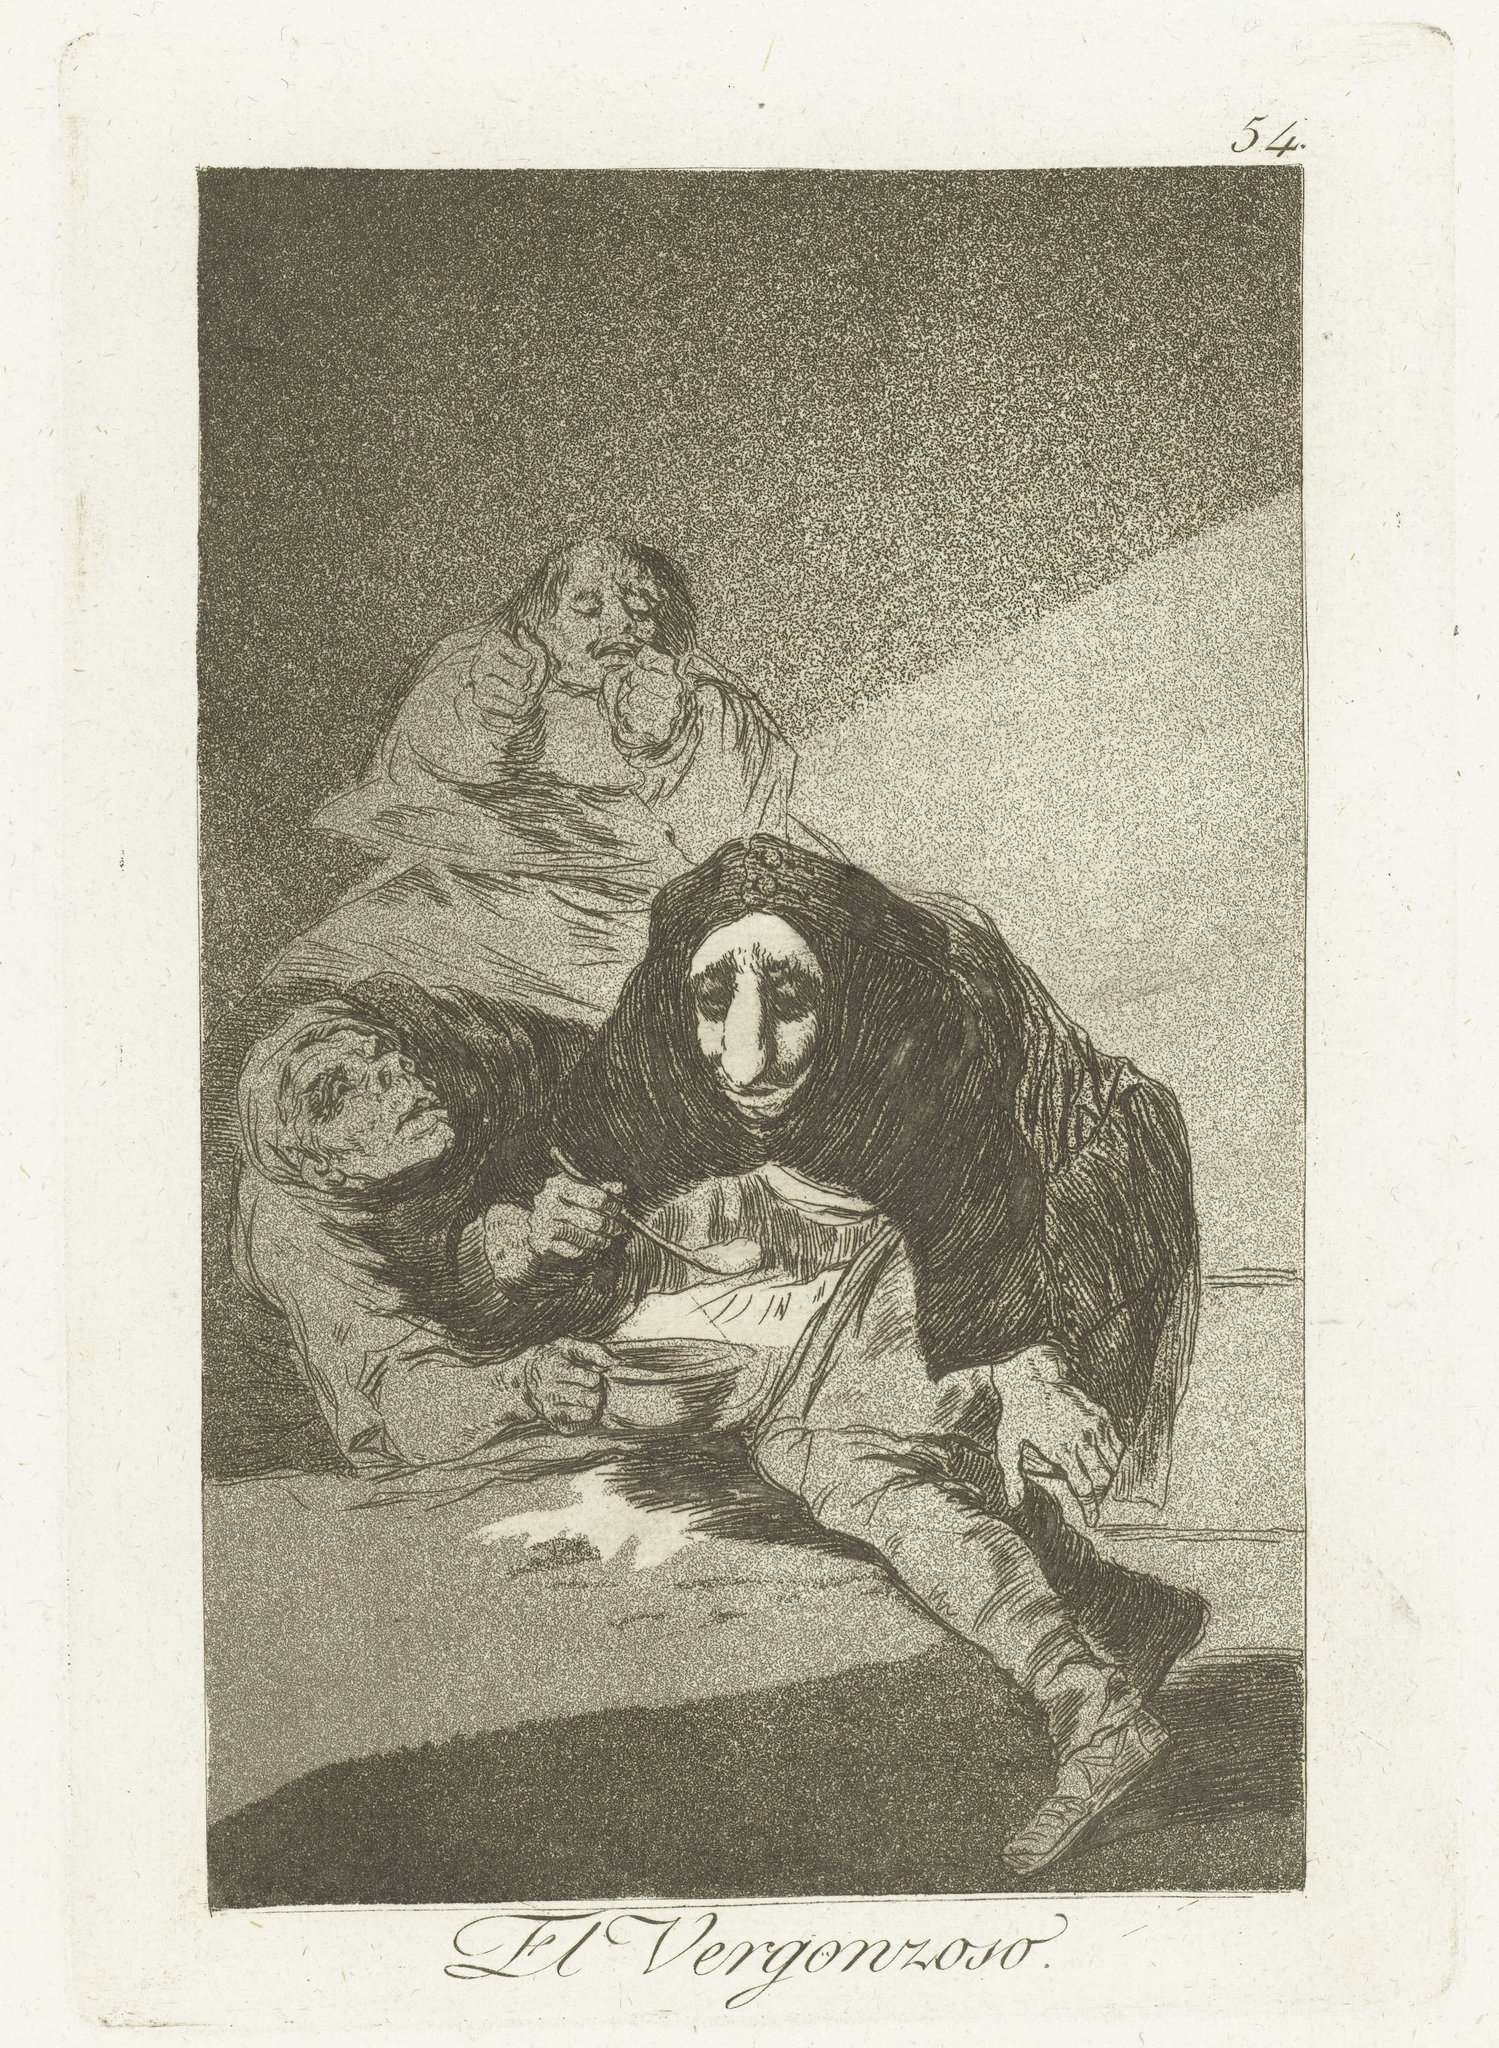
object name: print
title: El vergonzoso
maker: francisco de goya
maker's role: draughtsman, painter, print maker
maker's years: 1746-1828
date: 1797-1799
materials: paper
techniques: aquatint, etching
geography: spain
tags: shame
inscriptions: collector's mark: Lugt 2228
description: Een man met een grote neus, zijn jas over zijn hoofd getrokken en een lepel in de hand. Achter hem twee mannen, waarvan één een kom vasthoudt. Vierenvijftigste prent uit de serie Los Caprichos.